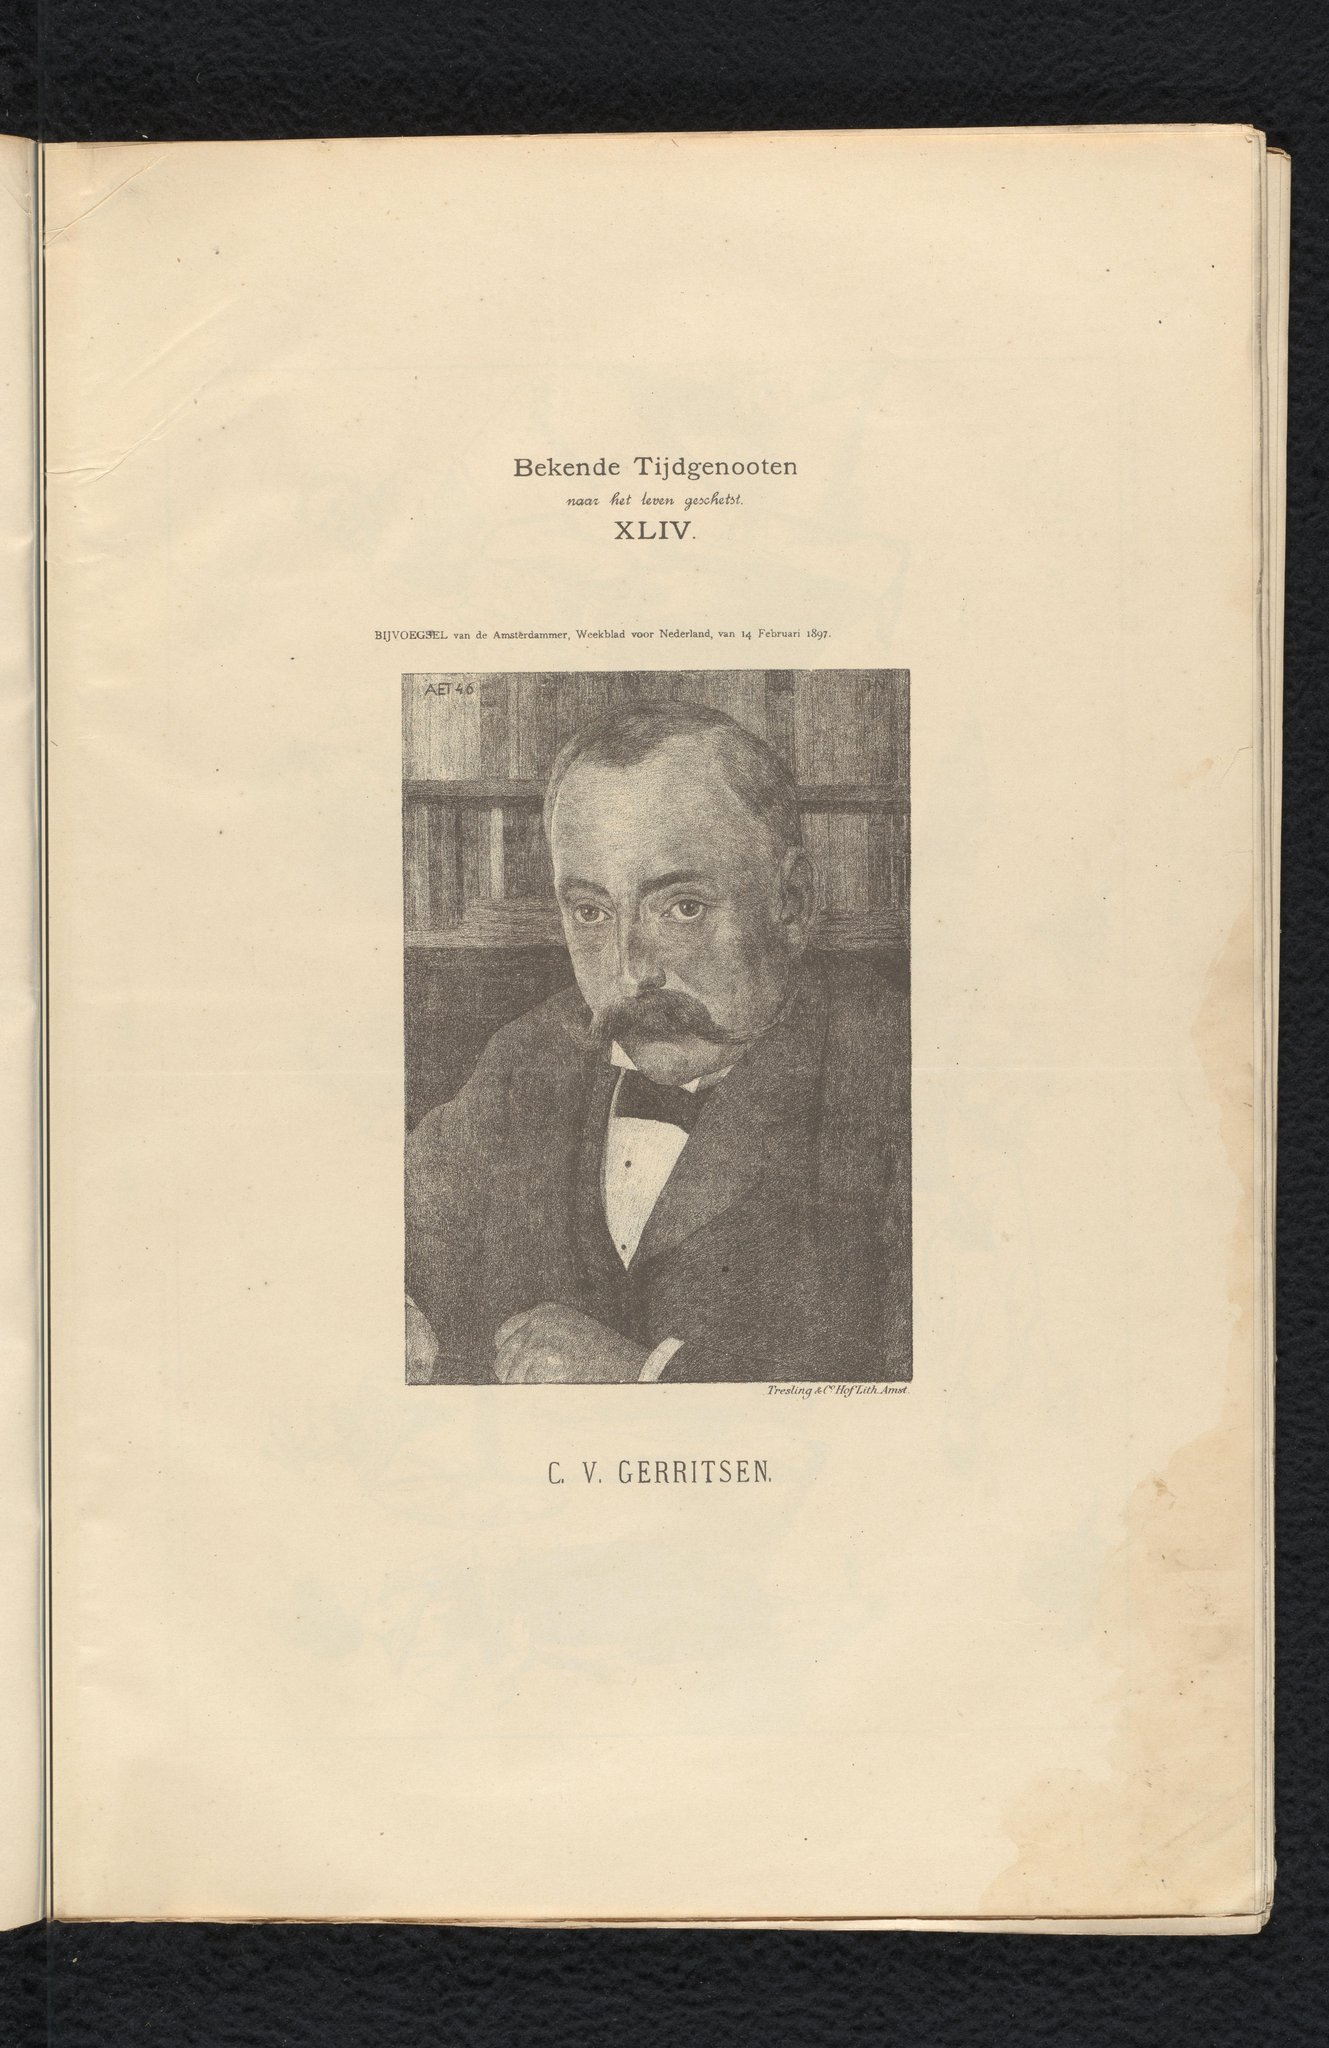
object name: print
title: C.V. Gerritsen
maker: ferdinand hart nibbrig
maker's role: draughtsman, painter, print maker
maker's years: 1866-1915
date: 1897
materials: paper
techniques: lithograph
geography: amsterdam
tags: politician, historical persons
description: Portret van Carel Victor Gerritsen, Nederlands politicus, wethouder in Amsterdam. In de serie 'Bekende Tijdgenooten', nr. XLIV.